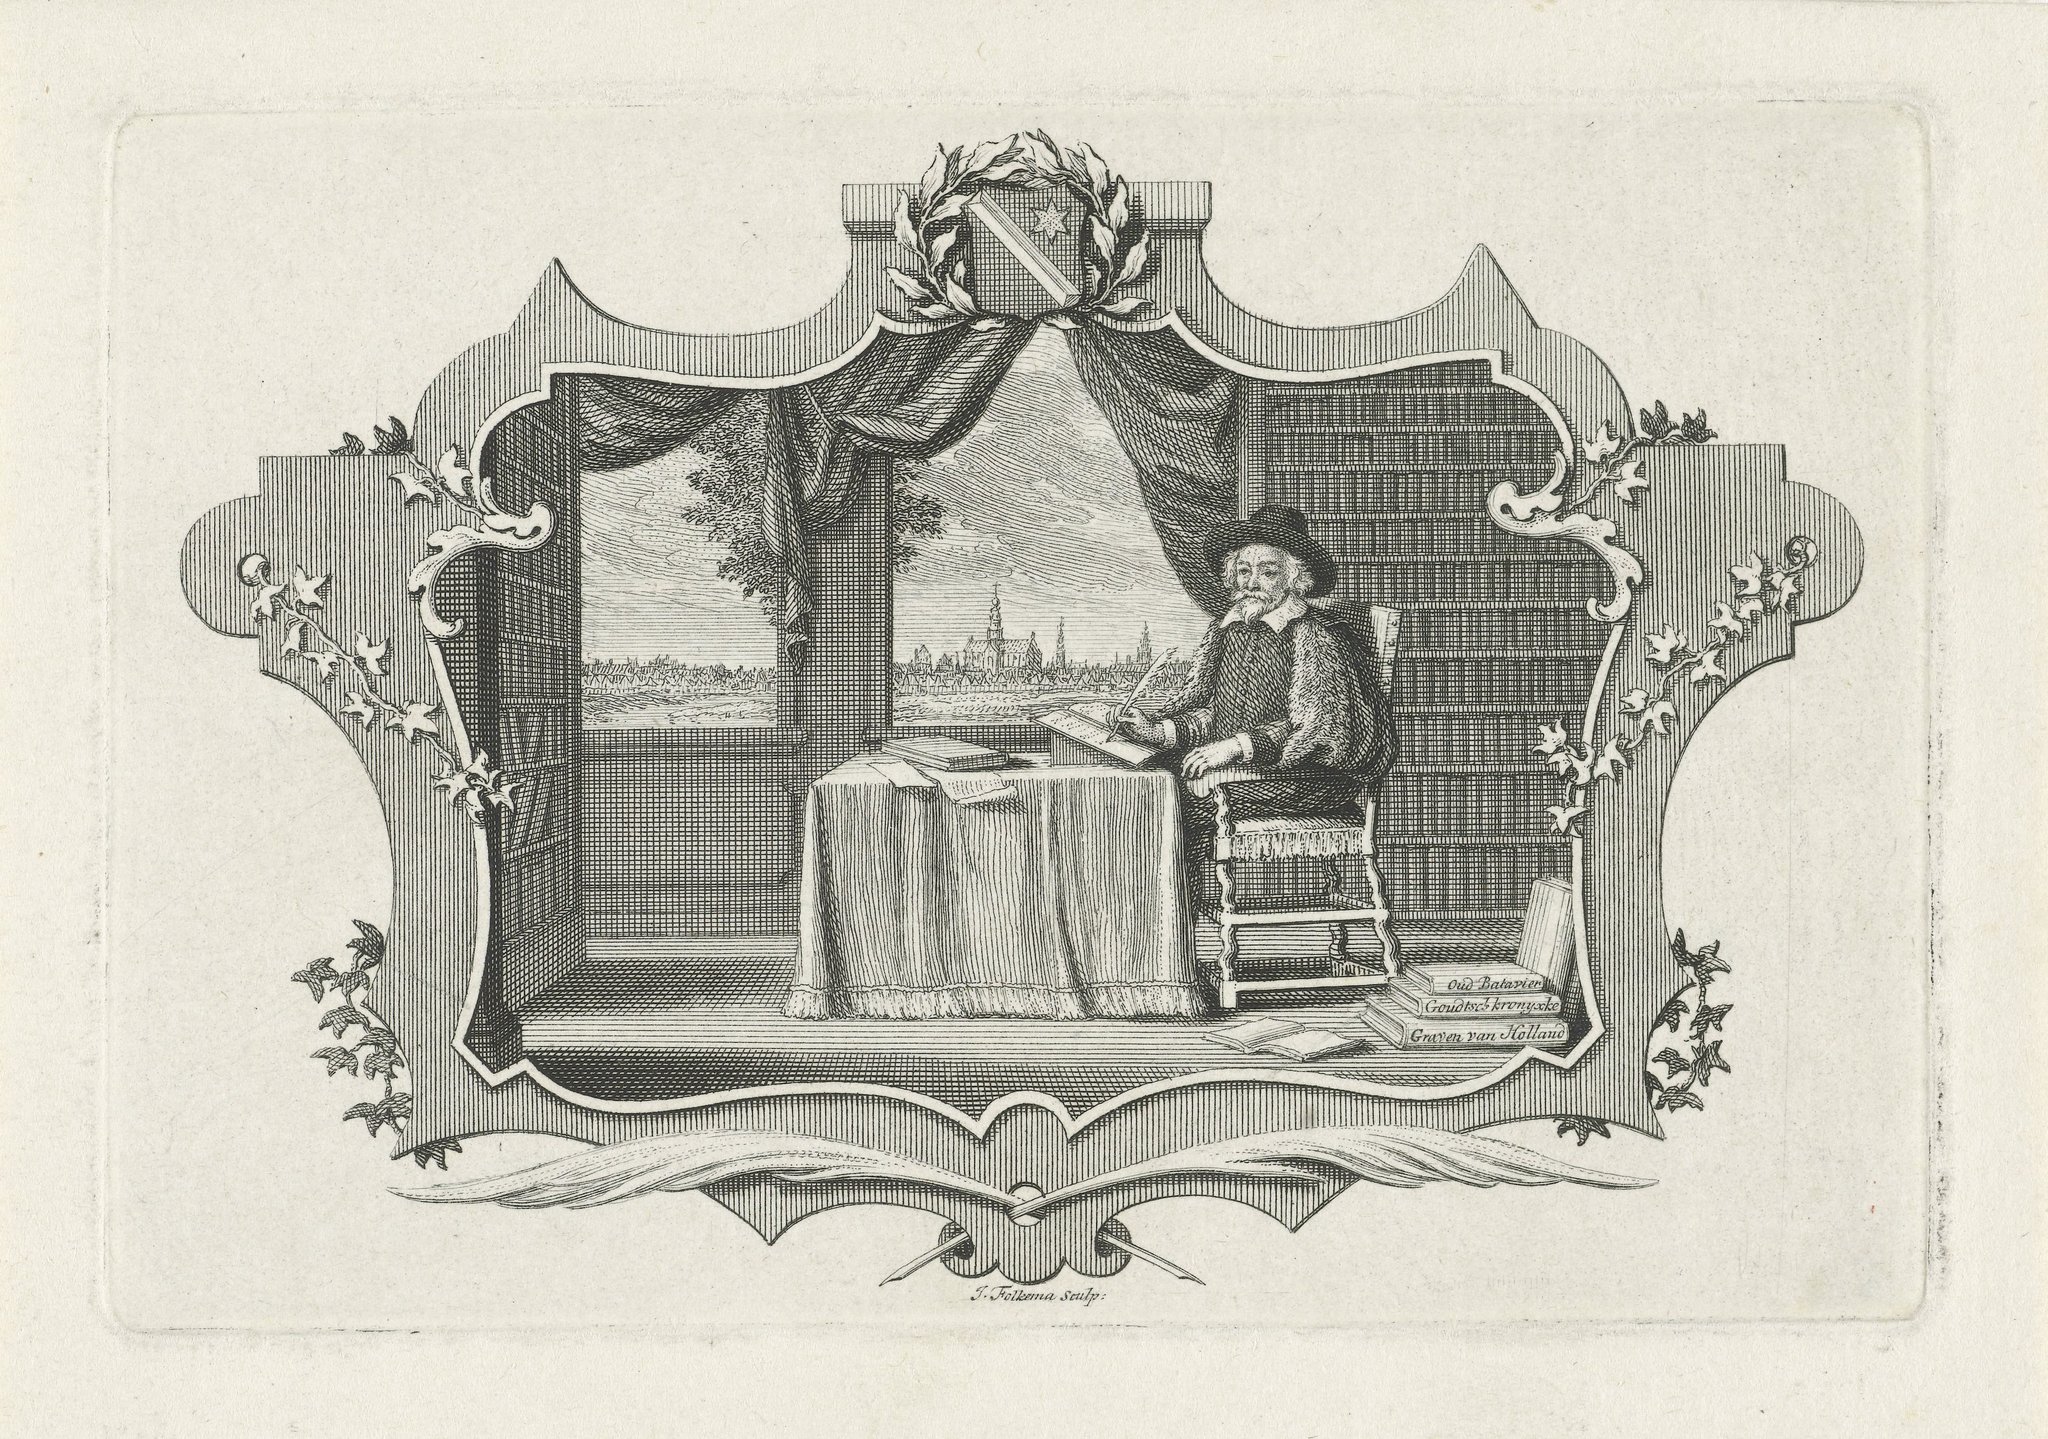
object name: print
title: Geleerde in zijn bibliotheek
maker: jacob folkema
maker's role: draughtsman, print maker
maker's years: 1692-1767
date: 1702-1767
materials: paper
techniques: etching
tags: petrus scriverius, study; 'studiolo'; library, armorial bearing, heraldry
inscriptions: collector's mark: Lugt 240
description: Een geleerde zit in zijn bibliotheek achter een bureau, door het raam zicht op een nabij gelegen stad. De voorstelling is gevat in een sierlijke lijst en gekroond met een wapenschild dat versierd is met olijftakken.